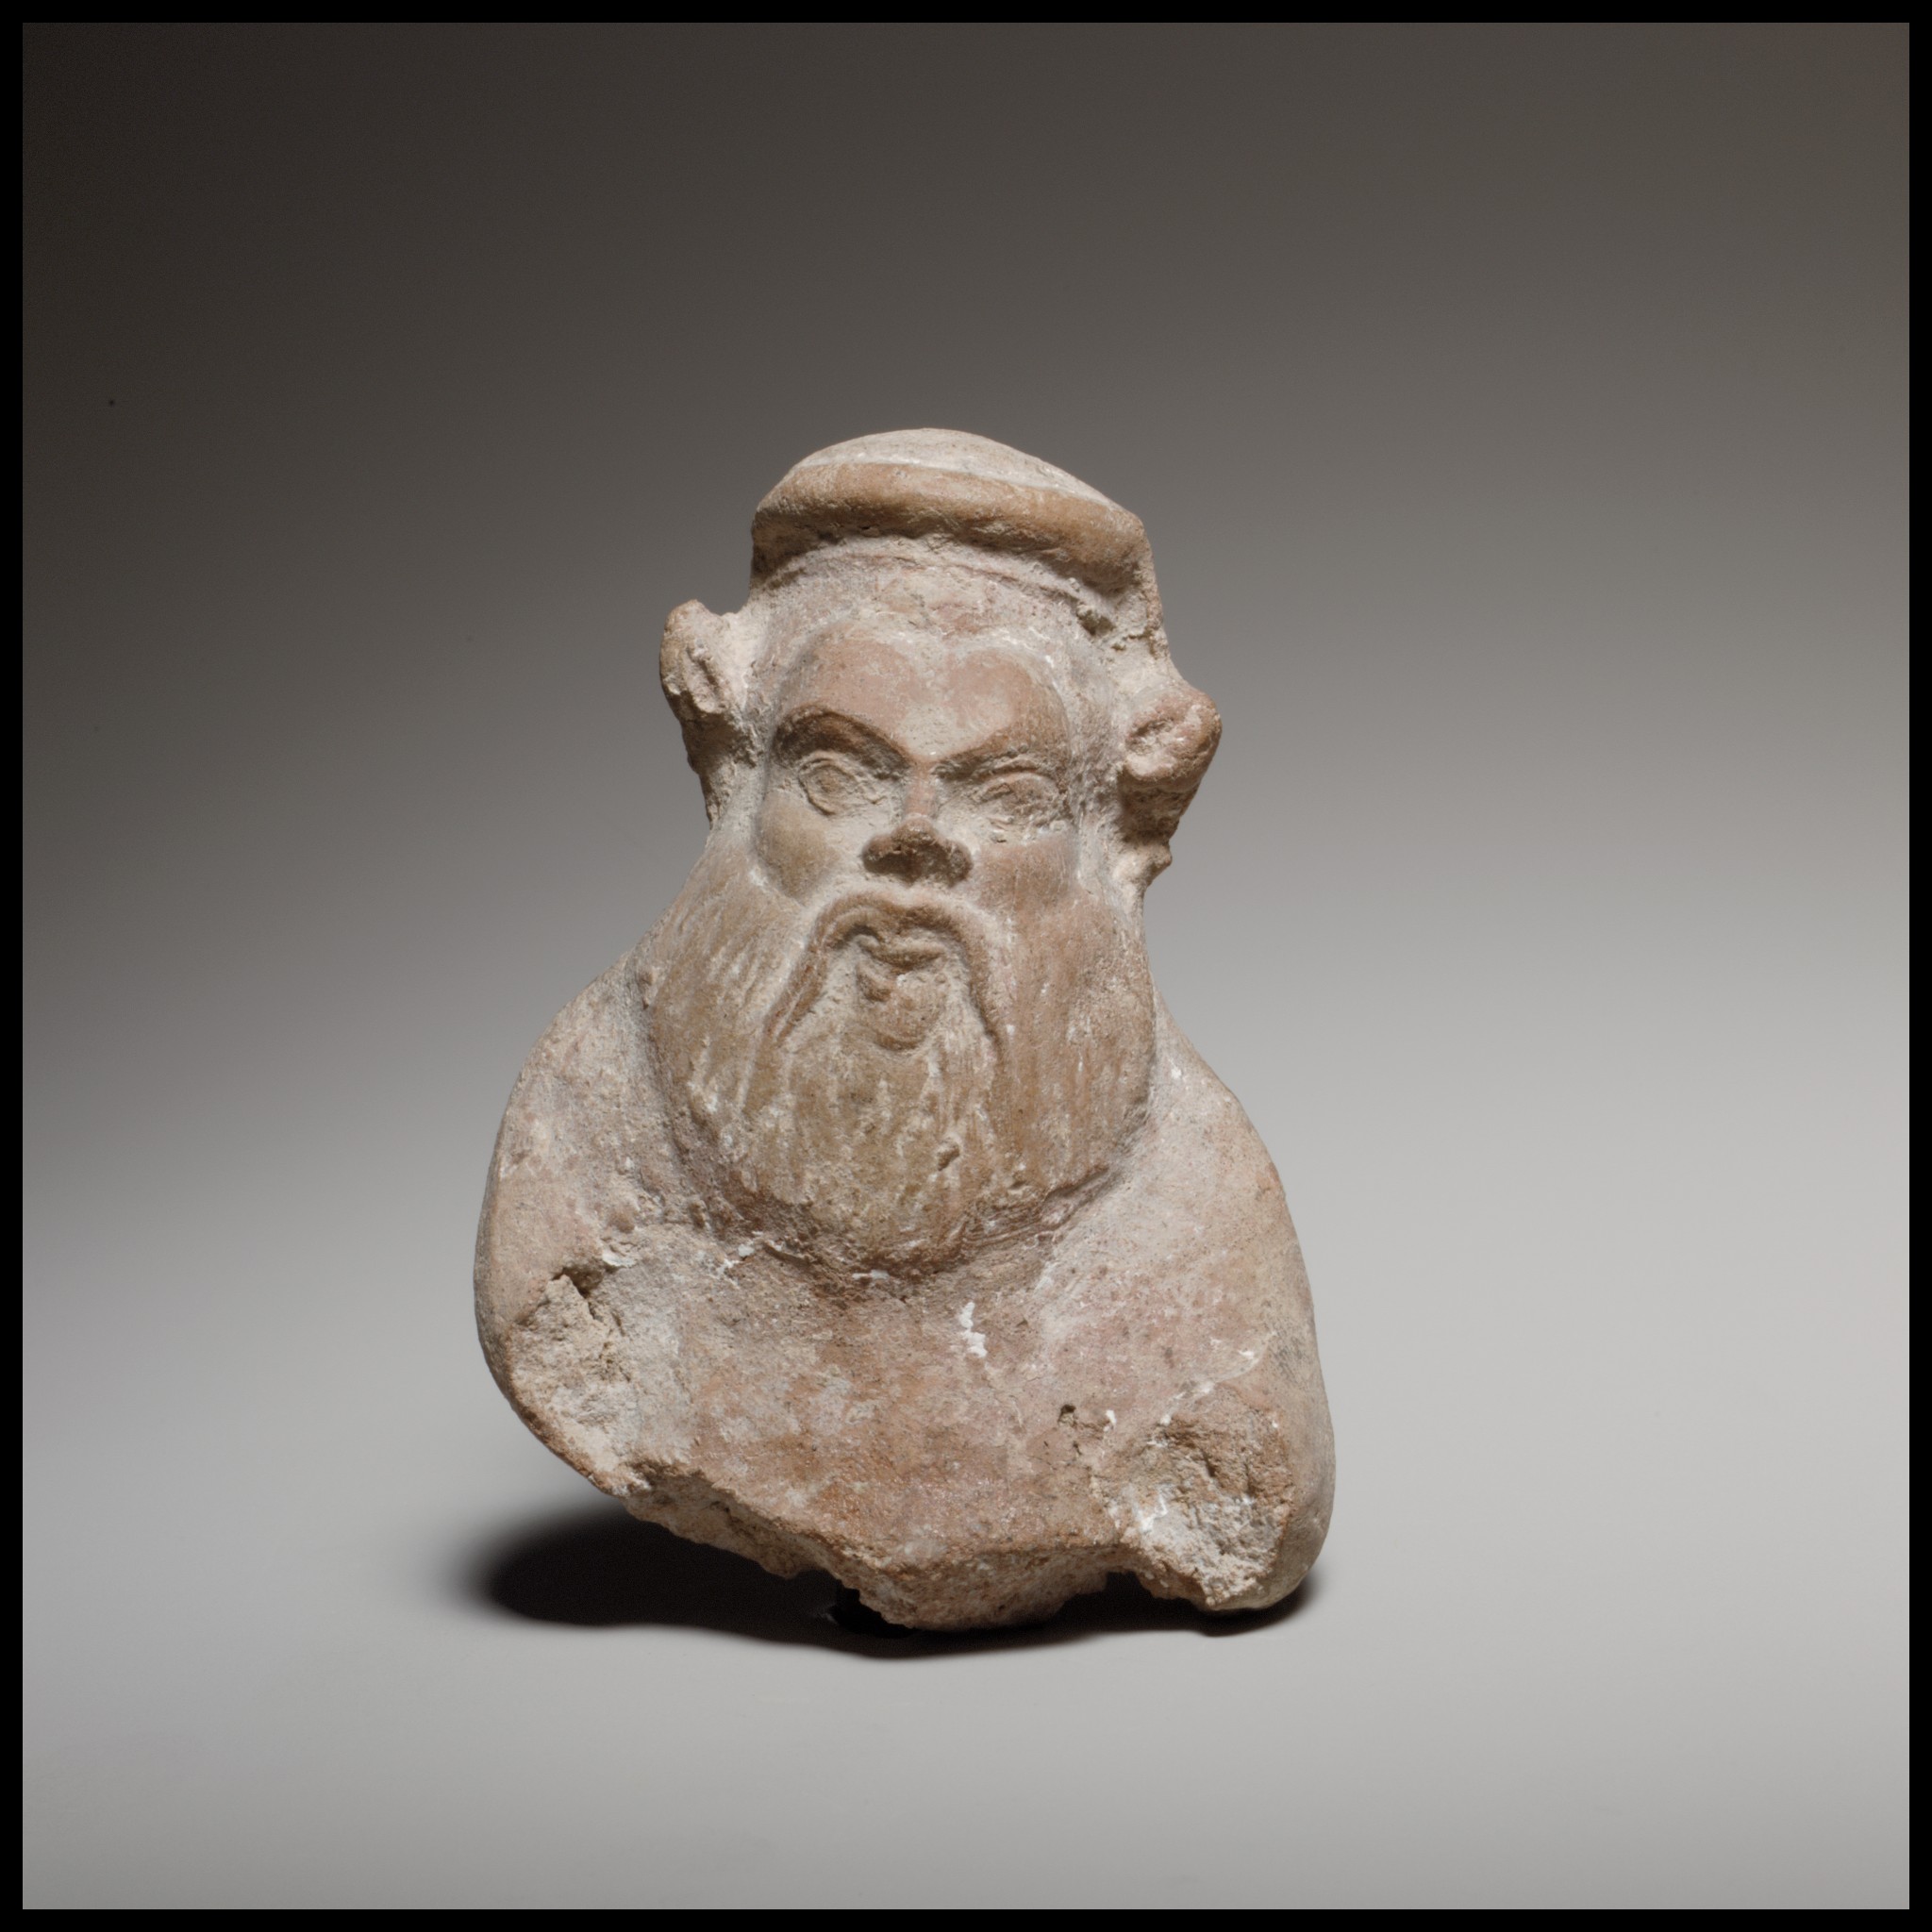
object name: statue of silenos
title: Silenos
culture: cypriot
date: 300-201 BCE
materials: terracotta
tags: silenus